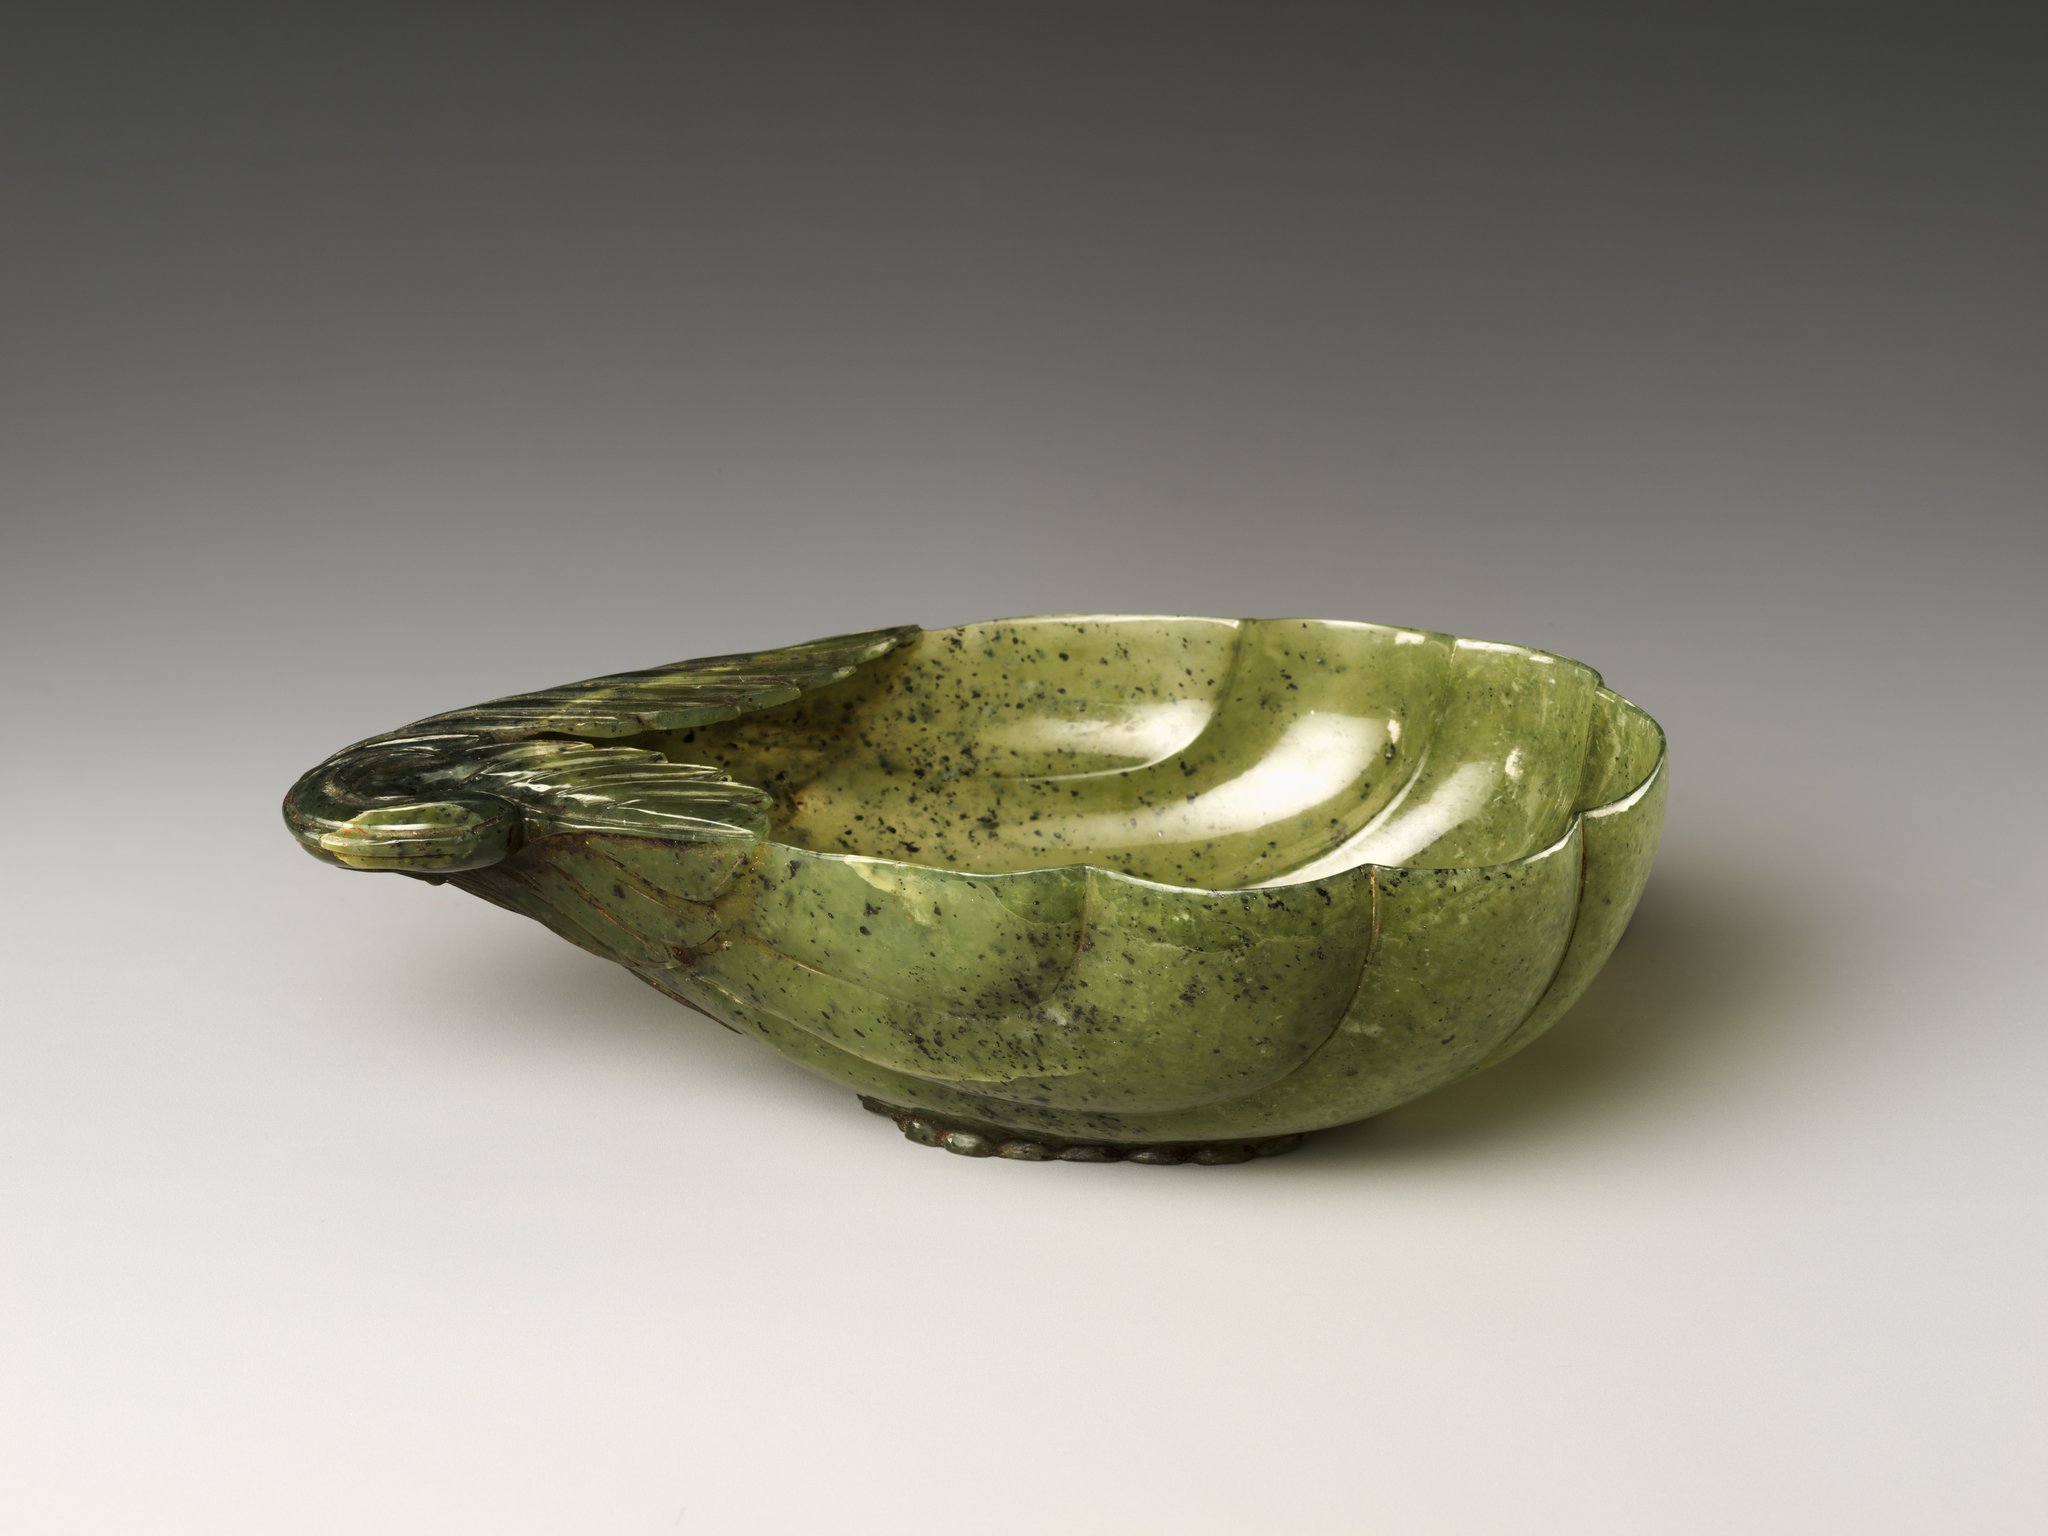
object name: wine cup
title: Bowl in shape of a shell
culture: indian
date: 1701-1800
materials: jade